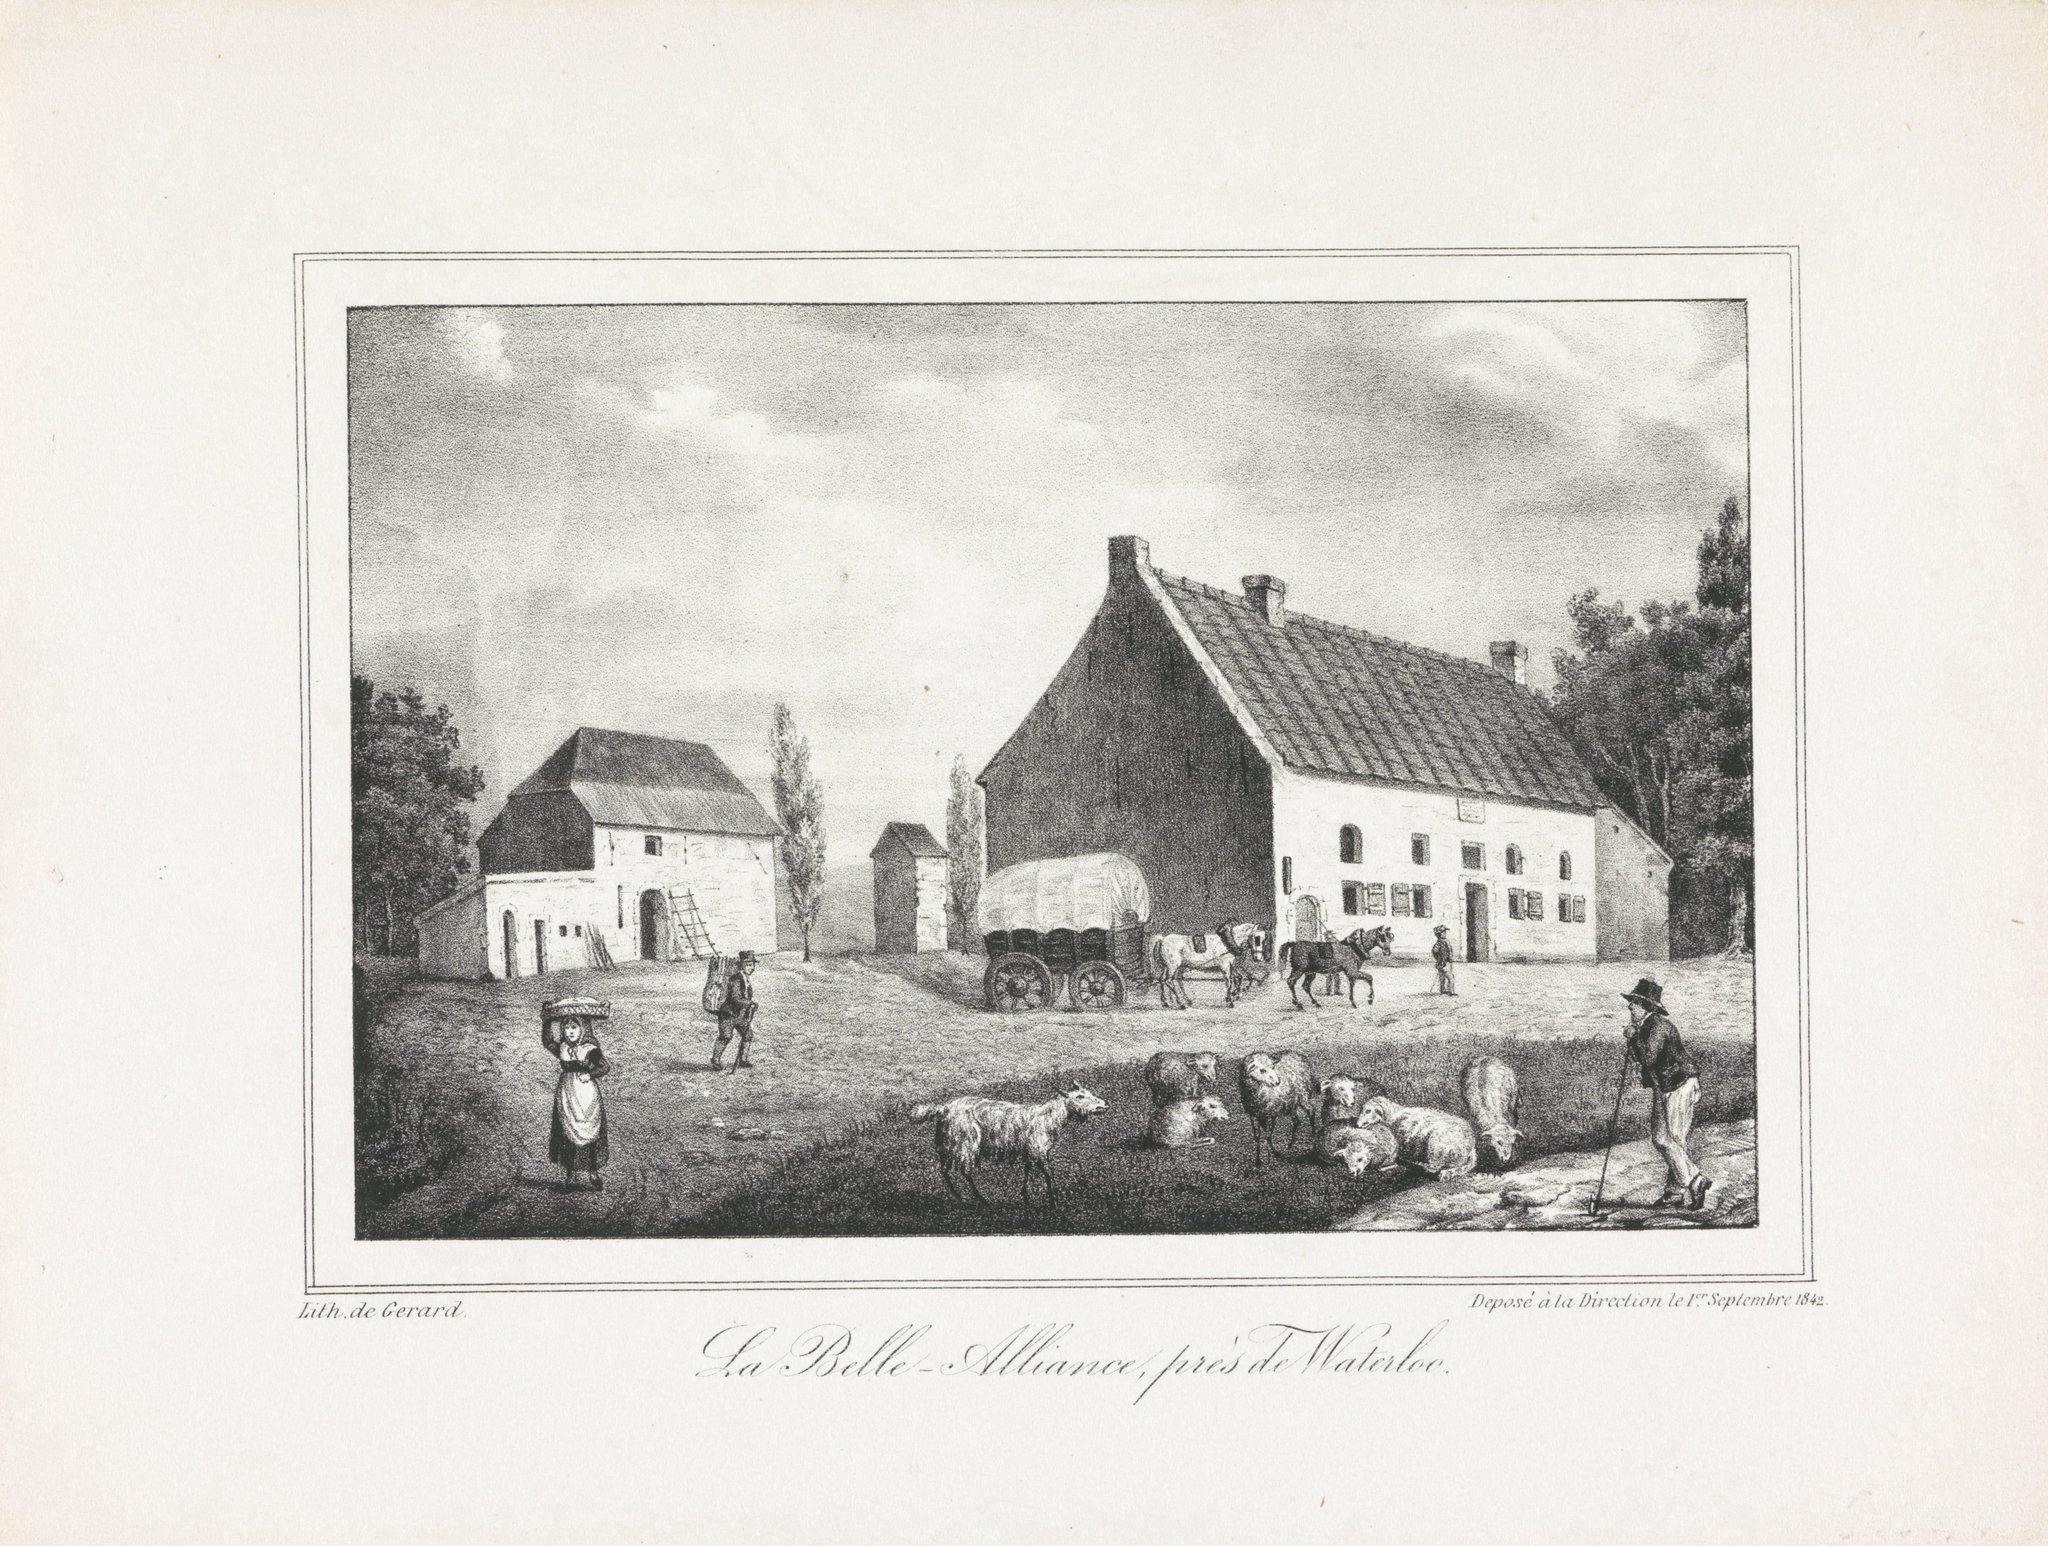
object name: print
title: La Belle-Alliance, près de Waterloo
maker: h. gérard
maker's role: printer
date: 1842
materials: paper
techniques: lithograph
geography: brussels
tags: farm (building), waterloo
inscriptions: collector's mark: Lugt 2228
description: Gezicht op de boerderij genaamd La Belle Alliance, nabij Waterloo. Rechts vooraan een schapenherder. Onderdeel van een serie van twaalf platen (aangevuld tot veertien) met gezichten uit ca. 1840 van de omgeving waar de slag bij Waterloo plaatsvond op 18 juni 1815.